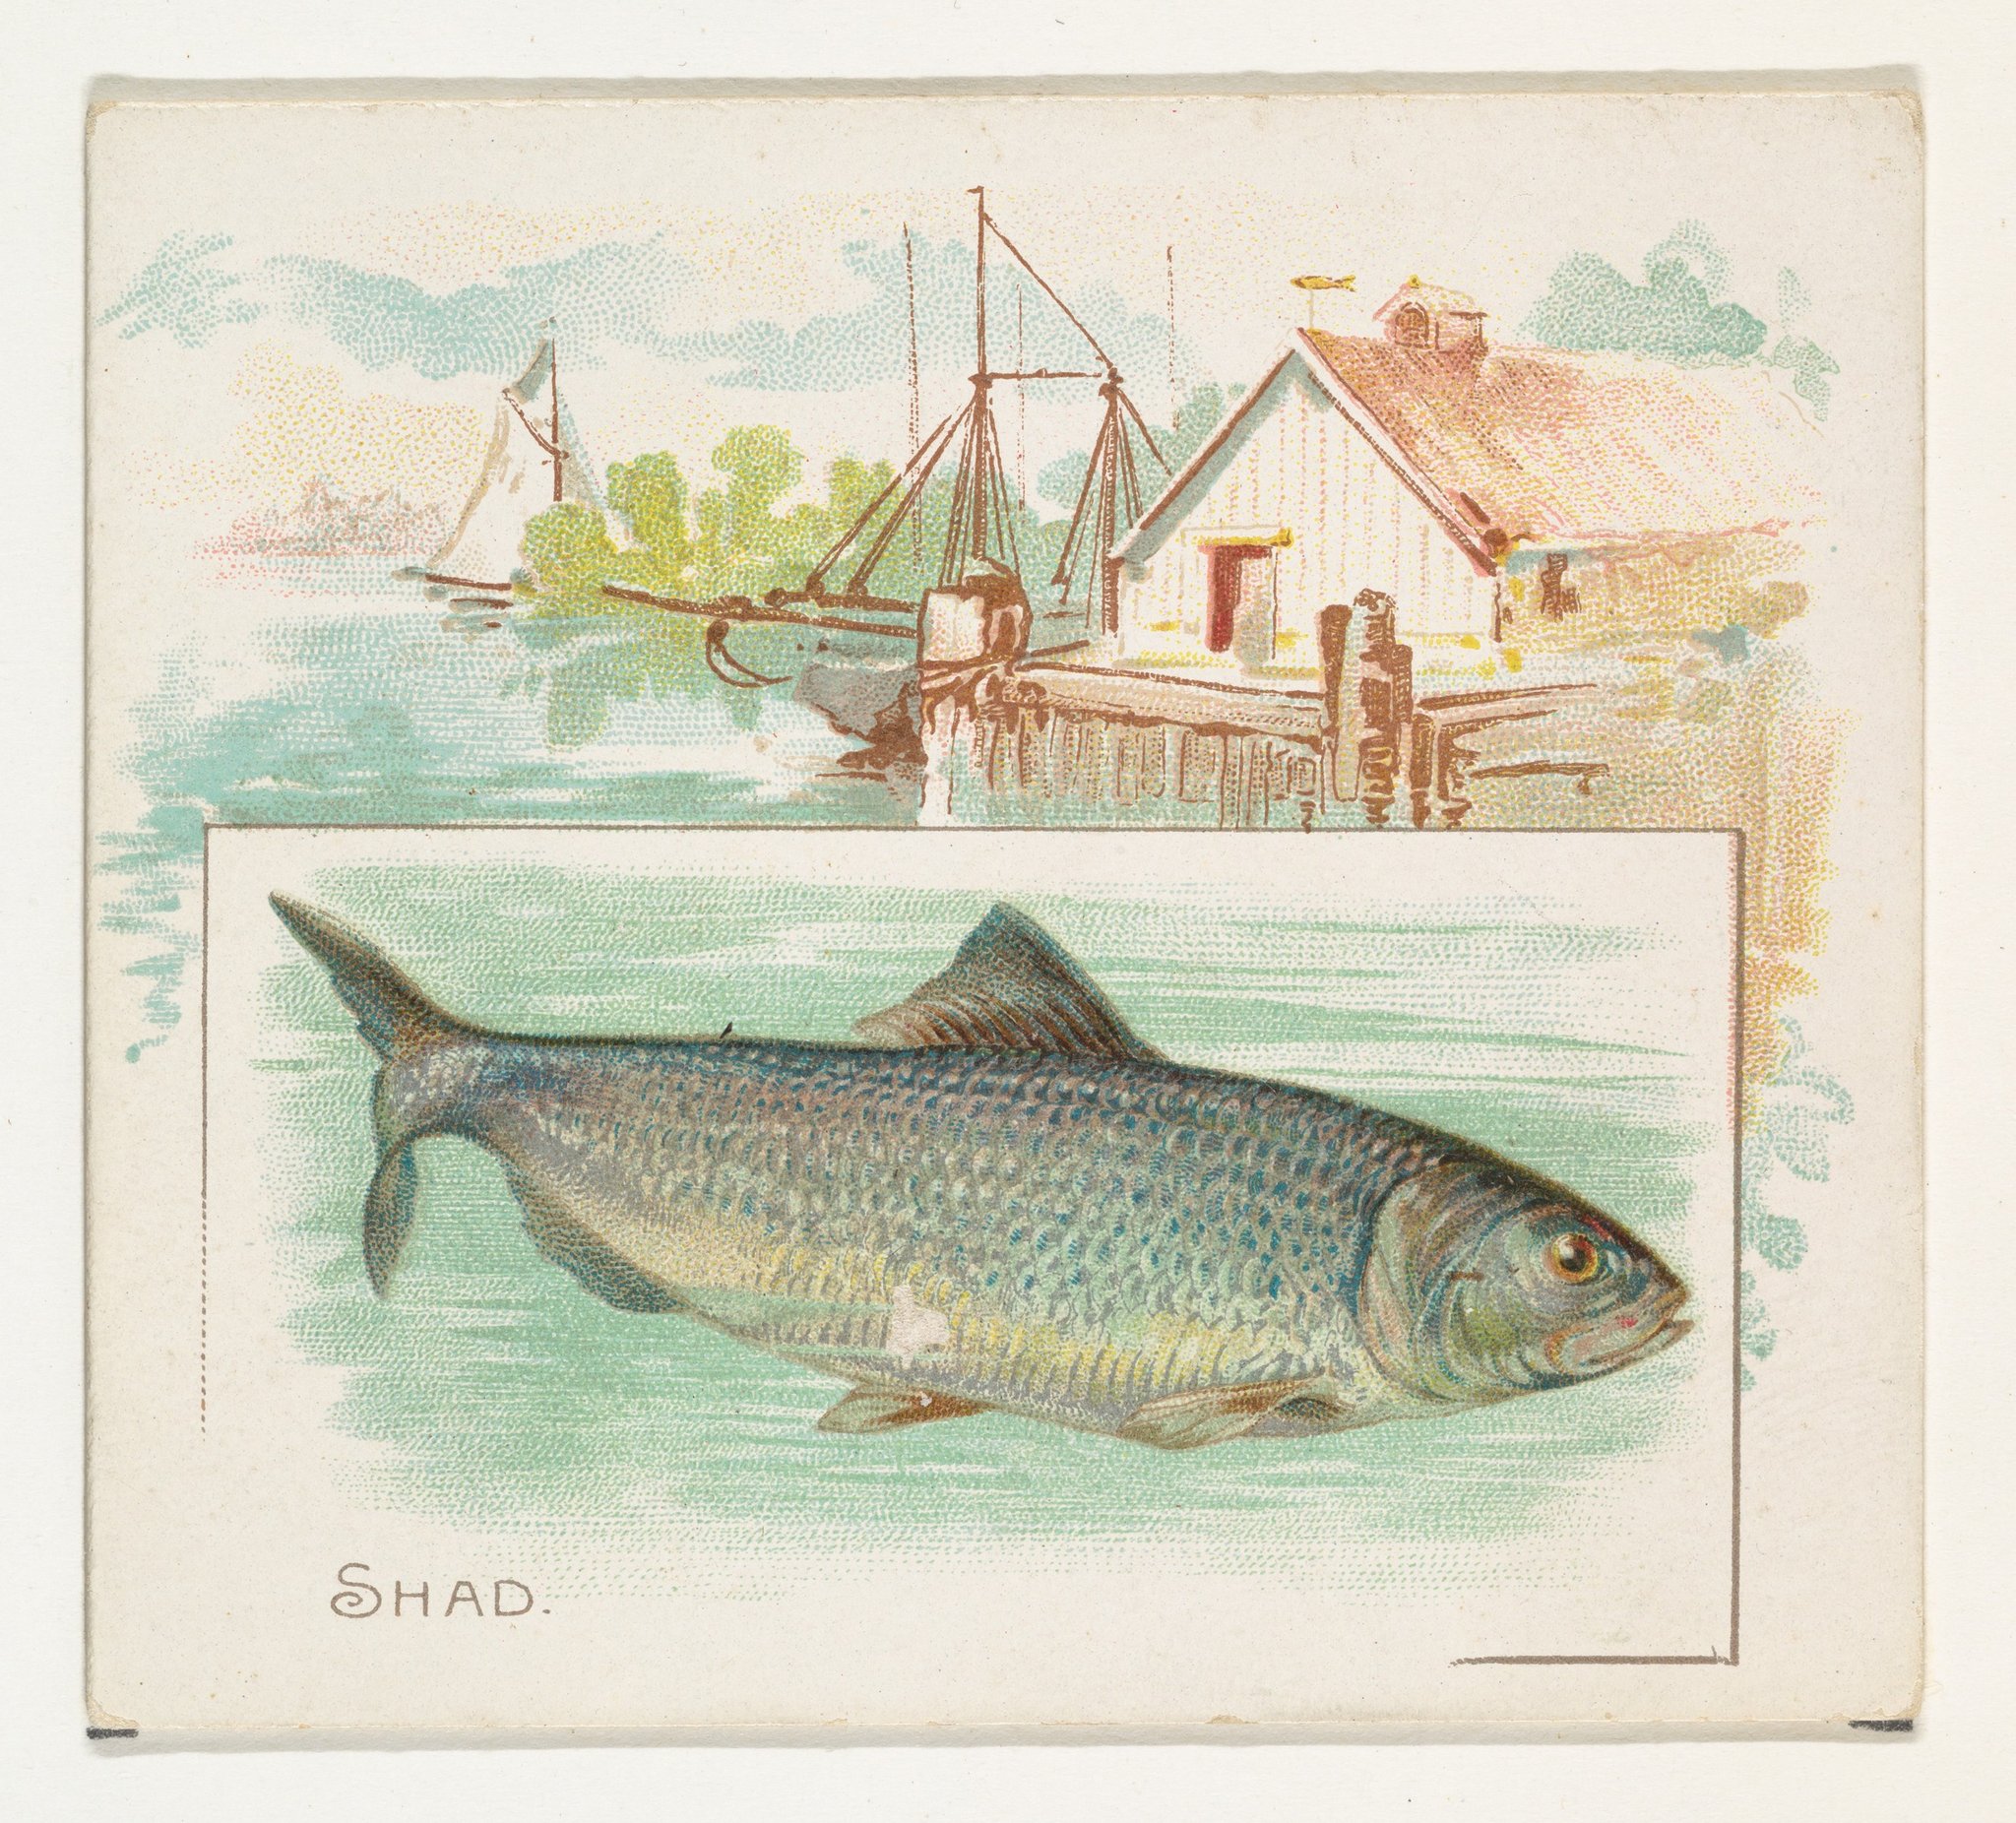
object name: print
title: Shad, from Fish from American Waters series (N39) for Allen & Ginter Cigarettes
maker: allen & ginter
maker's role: publisher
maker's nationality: american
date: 1889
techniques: color lithograph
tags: fish